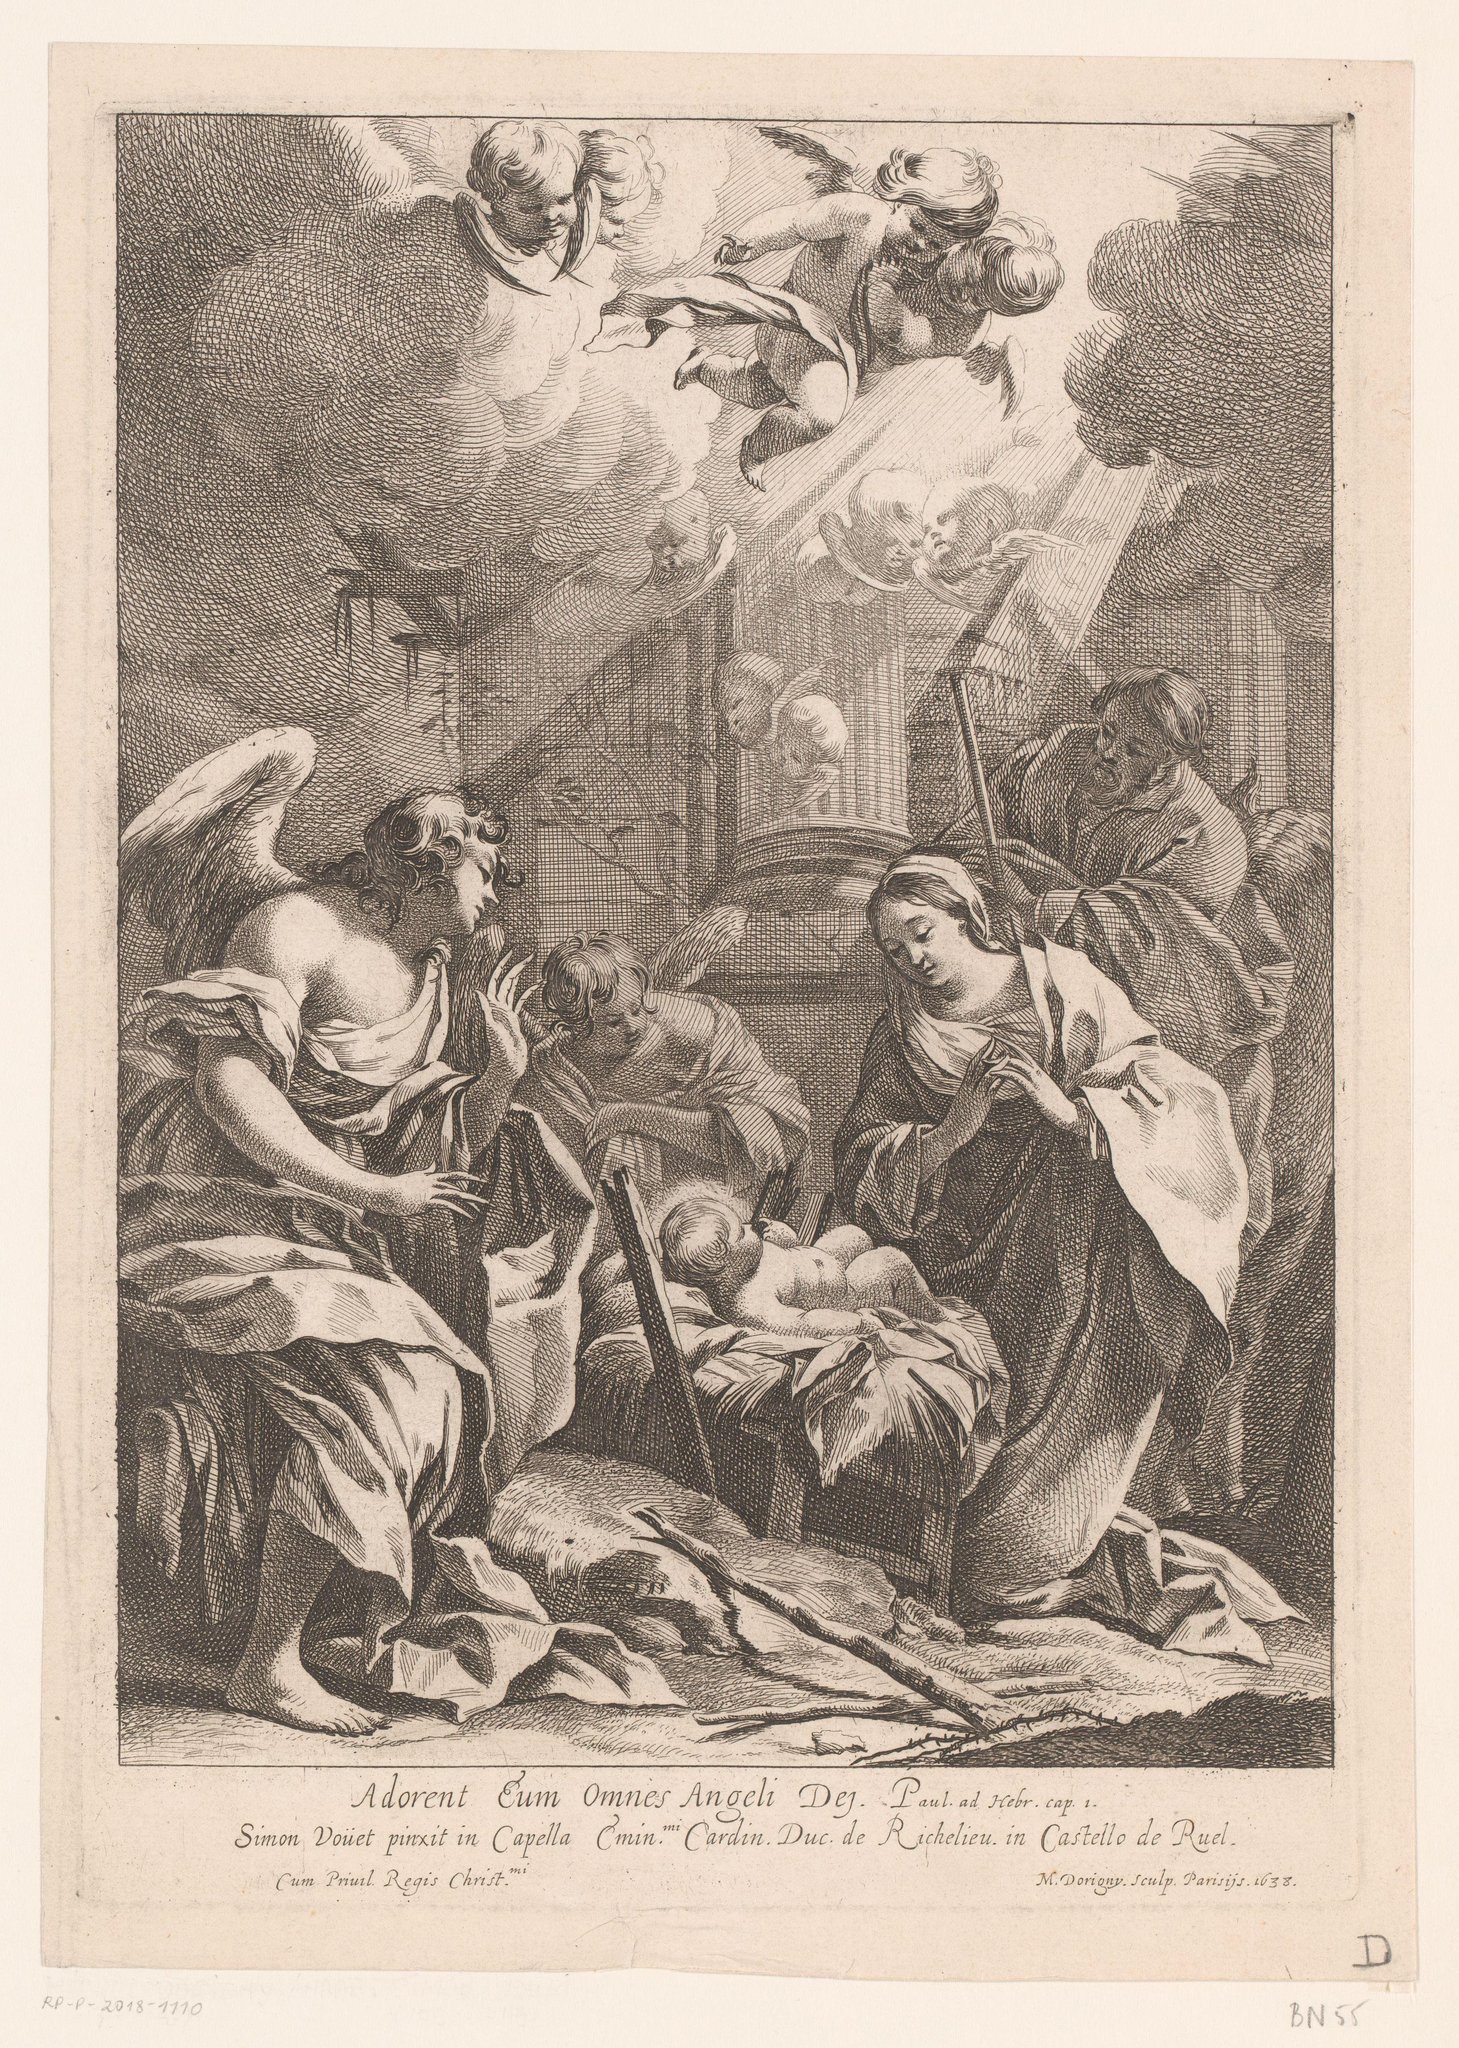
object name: print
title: Geboorte van Christus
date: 1638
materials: paper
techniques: engraving, etching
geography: paris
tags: angels in adoration, mary, joseph and the new-born christ (nativity)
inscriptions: collector's mark: Lugt 2228